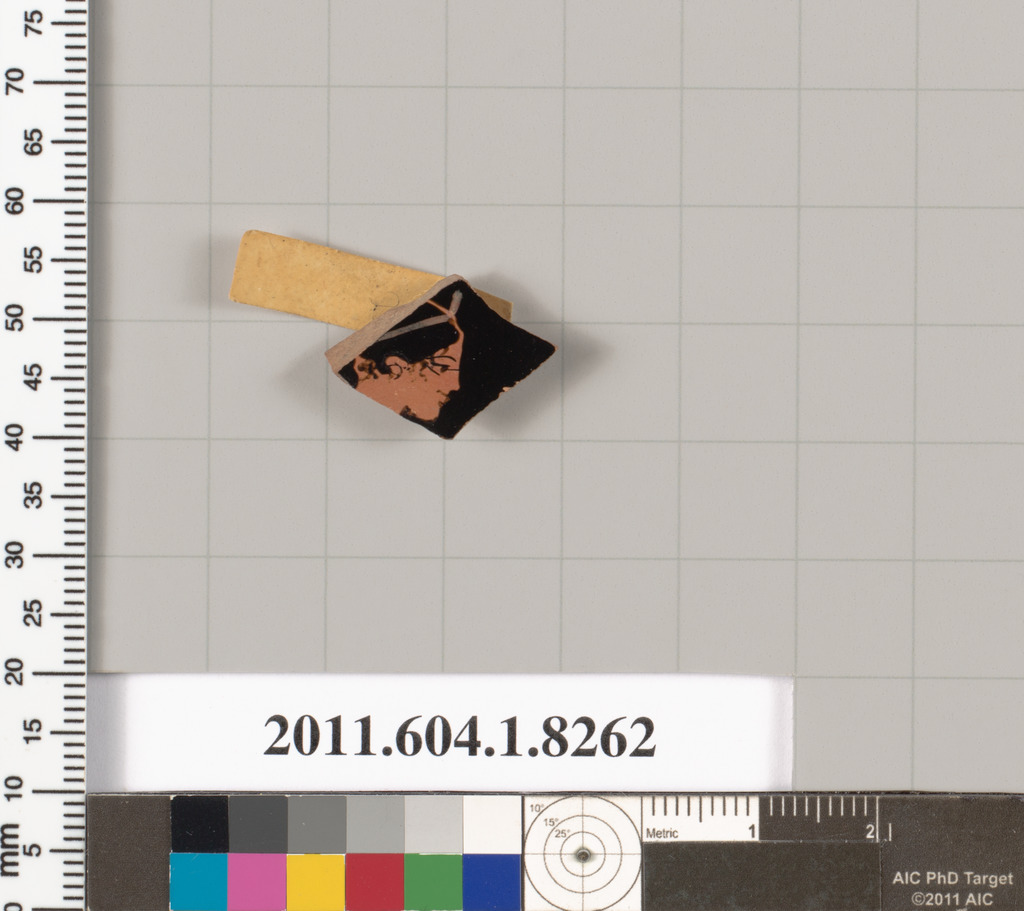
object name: kylix fragment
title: Terracotta fragment of a kylix (drinking cup)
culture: greek, attic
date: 470-460 BCE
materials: terracotta